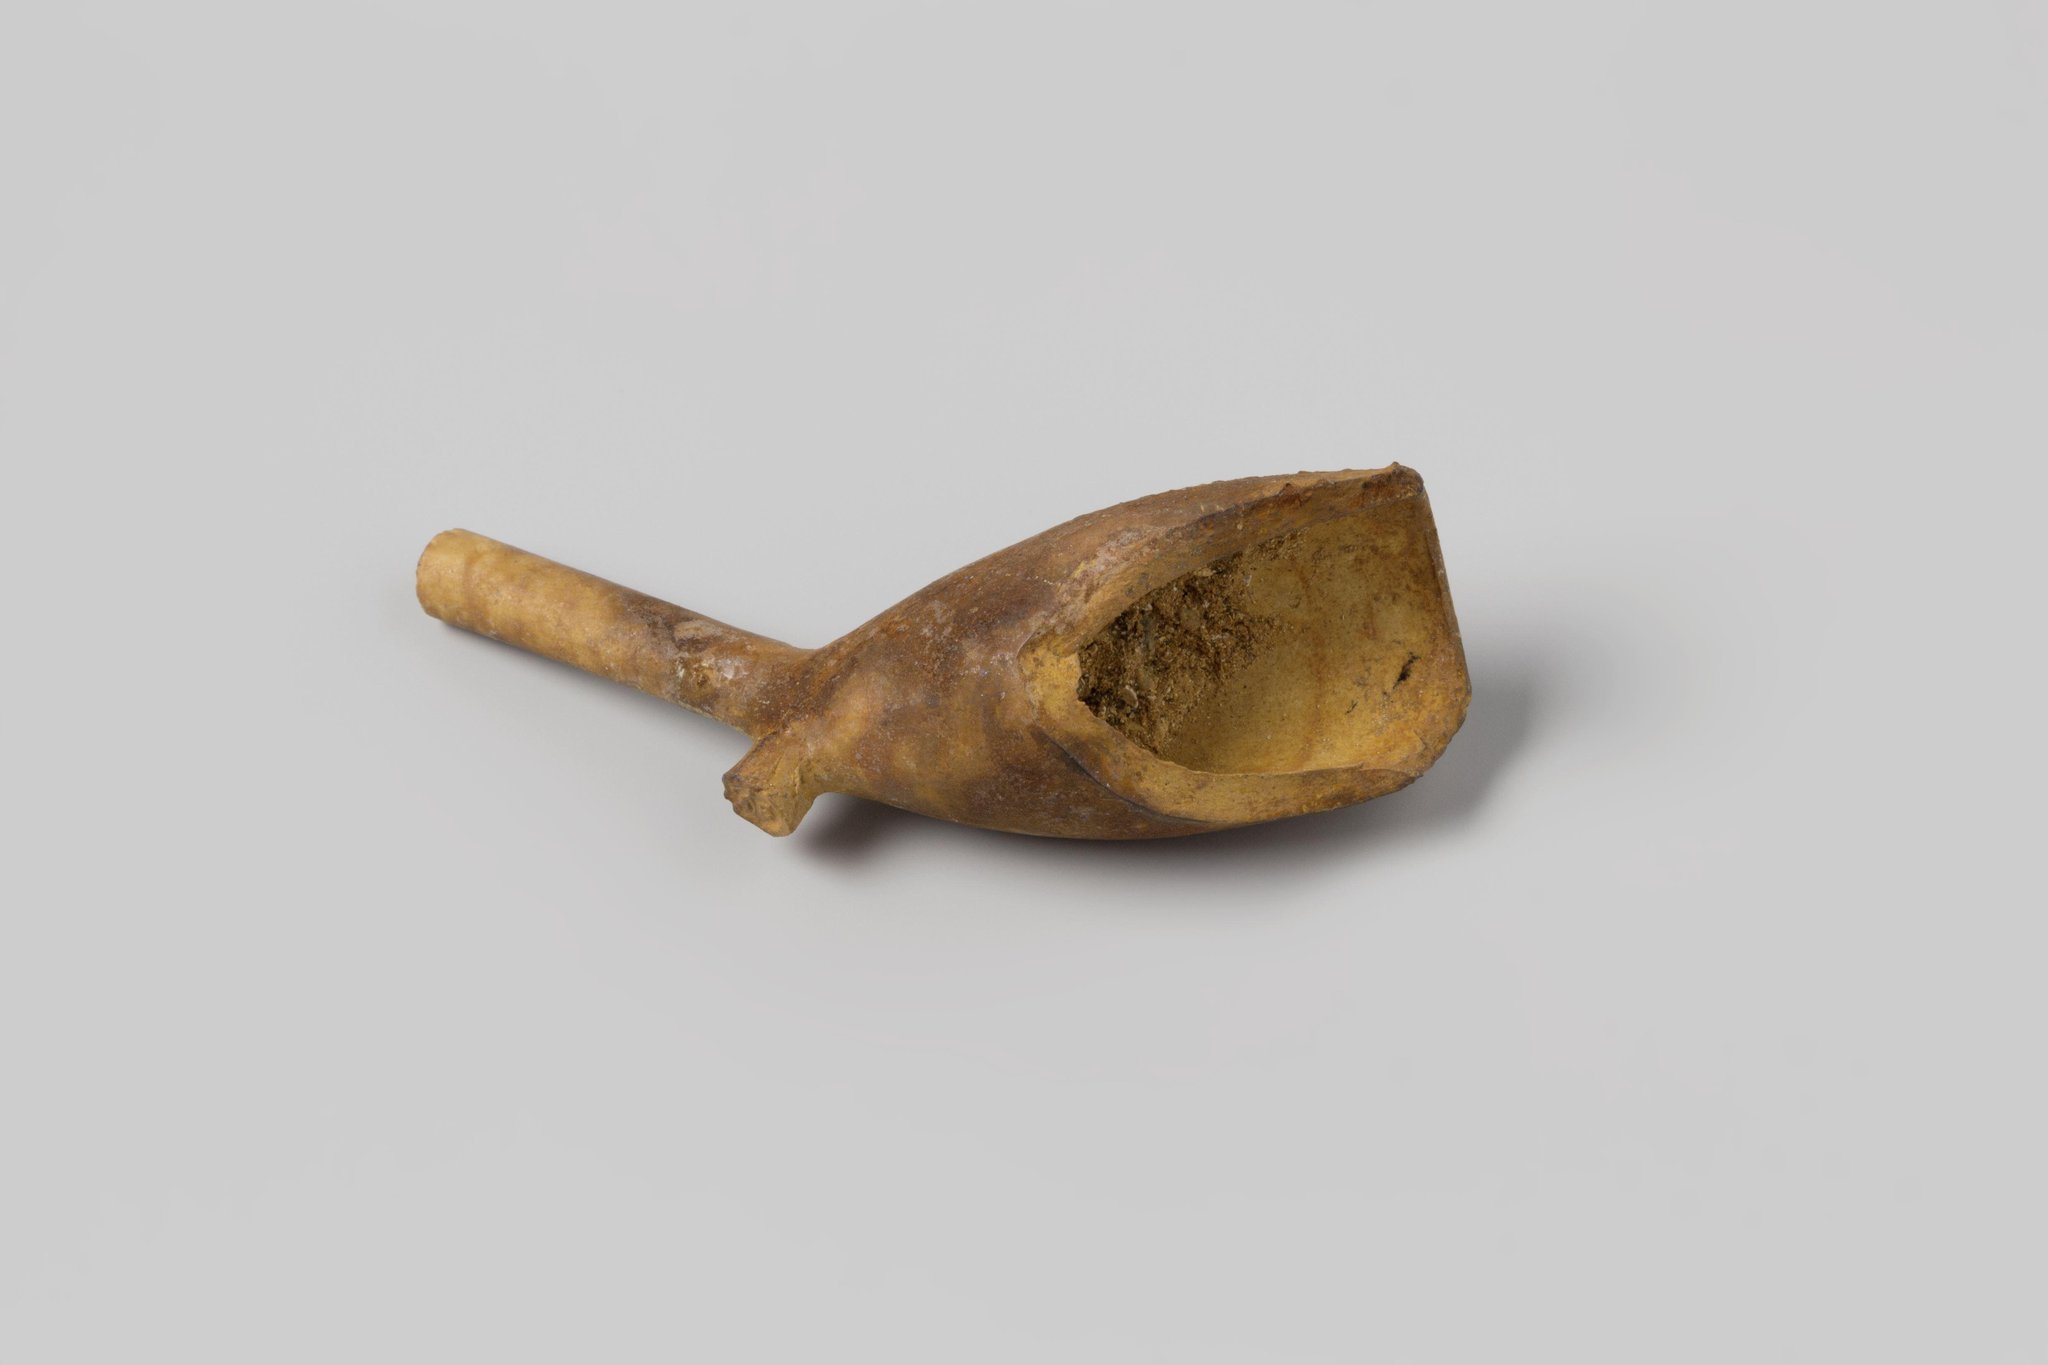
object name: pipe bowl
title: Fragment pijpenkop met stuk steel uit het wrak van de Oost-Indiëvaarder Hollandia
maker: Anonymous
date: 1700-1743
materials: clay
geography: netherlands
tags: verenigde oostindische compagnie, hollandia (schip), annet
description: Pipe, bowl, heelmark: tobacco's brazier; fragm, 2hsm1,3.